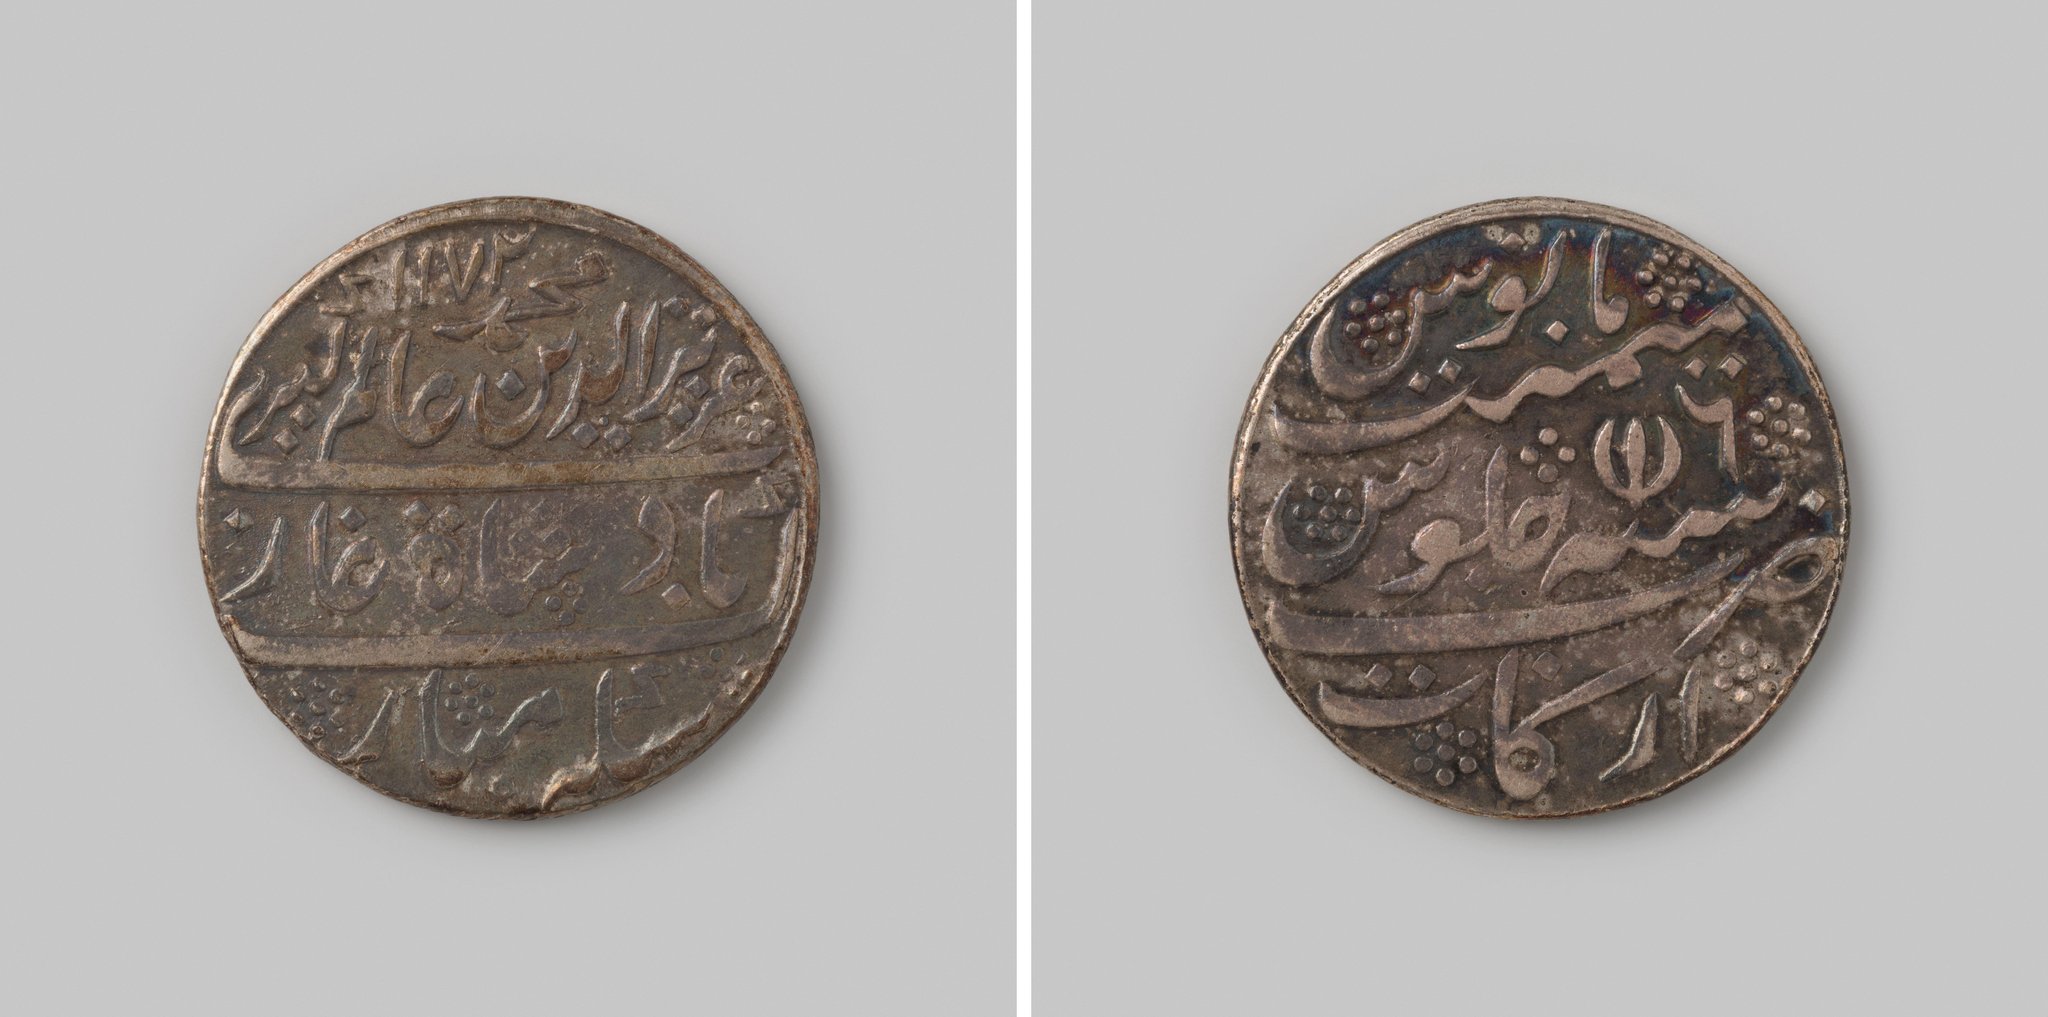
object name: coin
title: India, Engelse Oostindische Compagnie (EIC) , arcot-roepie voor Madras, India, op naam van shah Alamgir II, (1807)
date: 1807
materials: silver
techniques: striking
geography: chennai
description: Zilveren munt. Voorzijde: opschrift in drie regels in Arabische lettertekens, waarin verwijzing naar shah Alamgir II. Links boven "bevroren" jaartal: 1172. Keerzijde: opschrift in drie regels in Arabische lettertekens. Boven tweede regel rechts aanduiding regeringsjaar: 6 en daarnaast lotusbloem. Kabelrand.